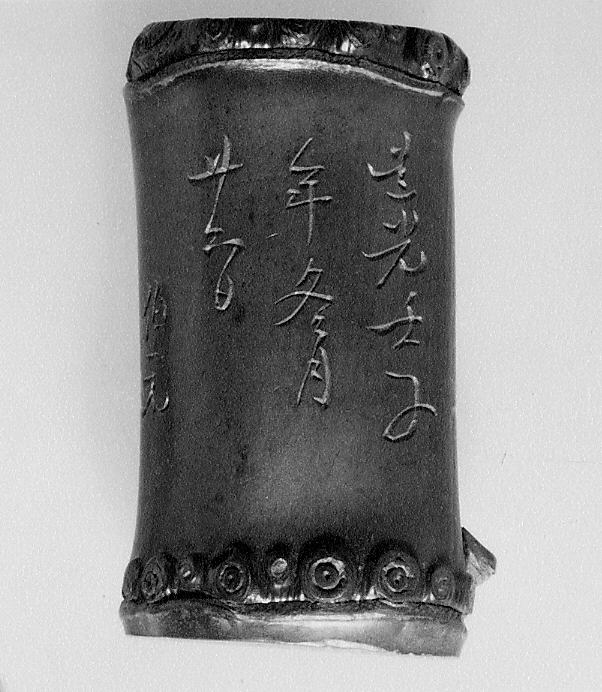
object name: seal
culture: chinese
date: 1736-1795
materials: bamboo